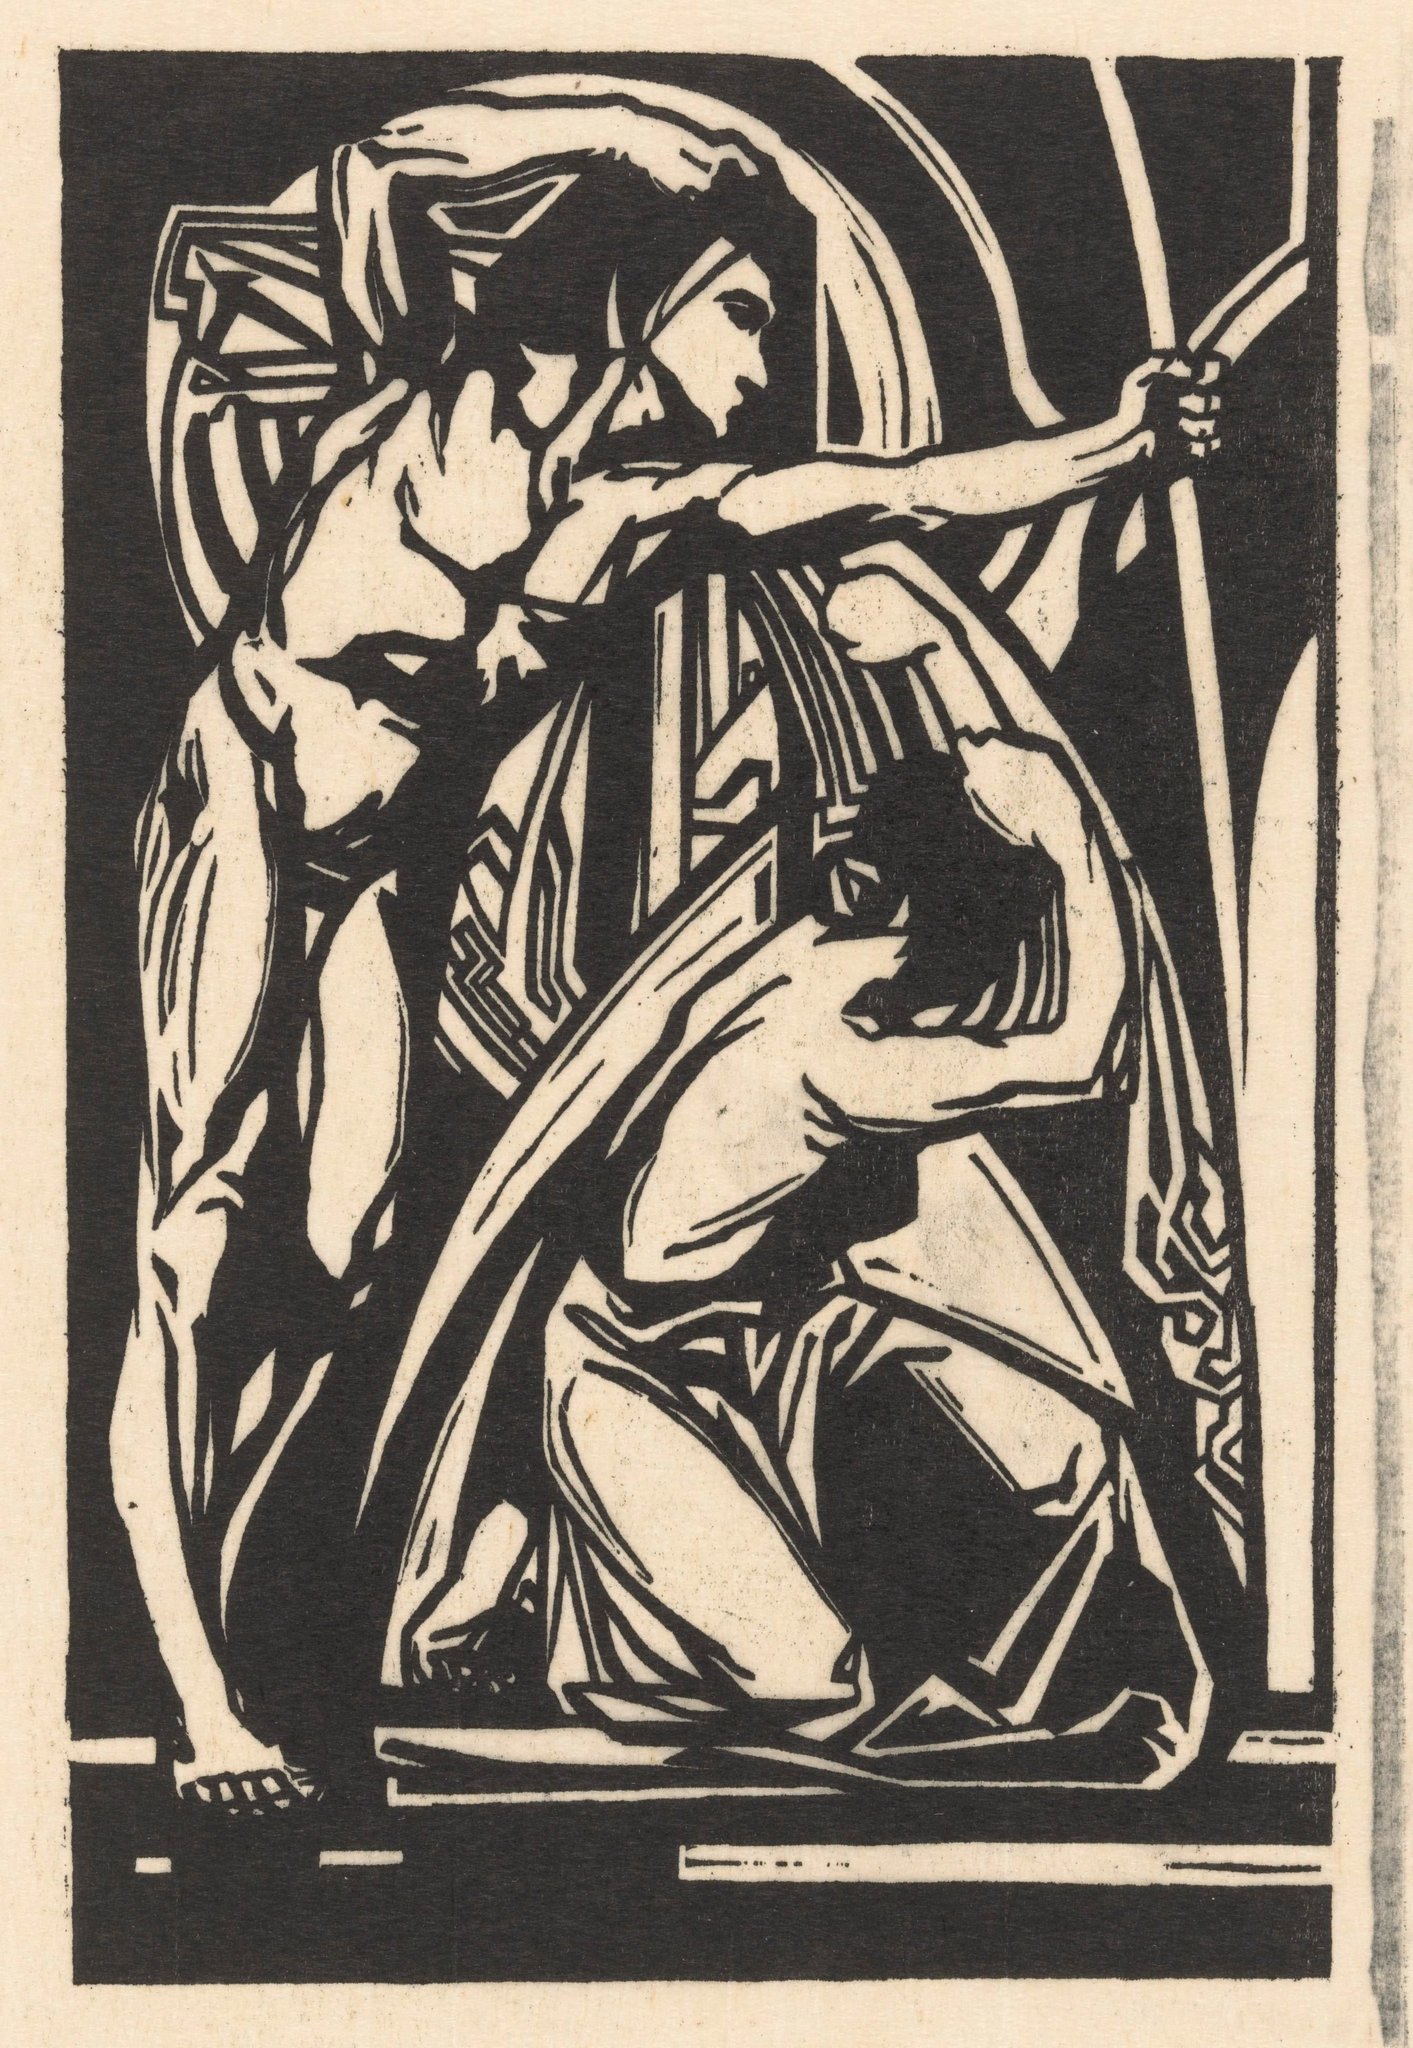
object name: print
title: Staande man en knielende vrouw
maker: johannes josephus aarts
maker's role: draughtsman, print maker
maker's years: 1871-1934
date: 1881-1934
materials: paper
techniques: woodcut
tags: (showing oneself) undressed, quasi-nude, kneeling figure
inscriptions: collector's mark: Lugt 2228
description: Een naakte, staande man, die zijn armen zo houdt alsof hij met pijl en boog schiet. Rechts van hem een halfnaakte, knielende vrouw, die twee gebalde vuisten in de lucht steekt.